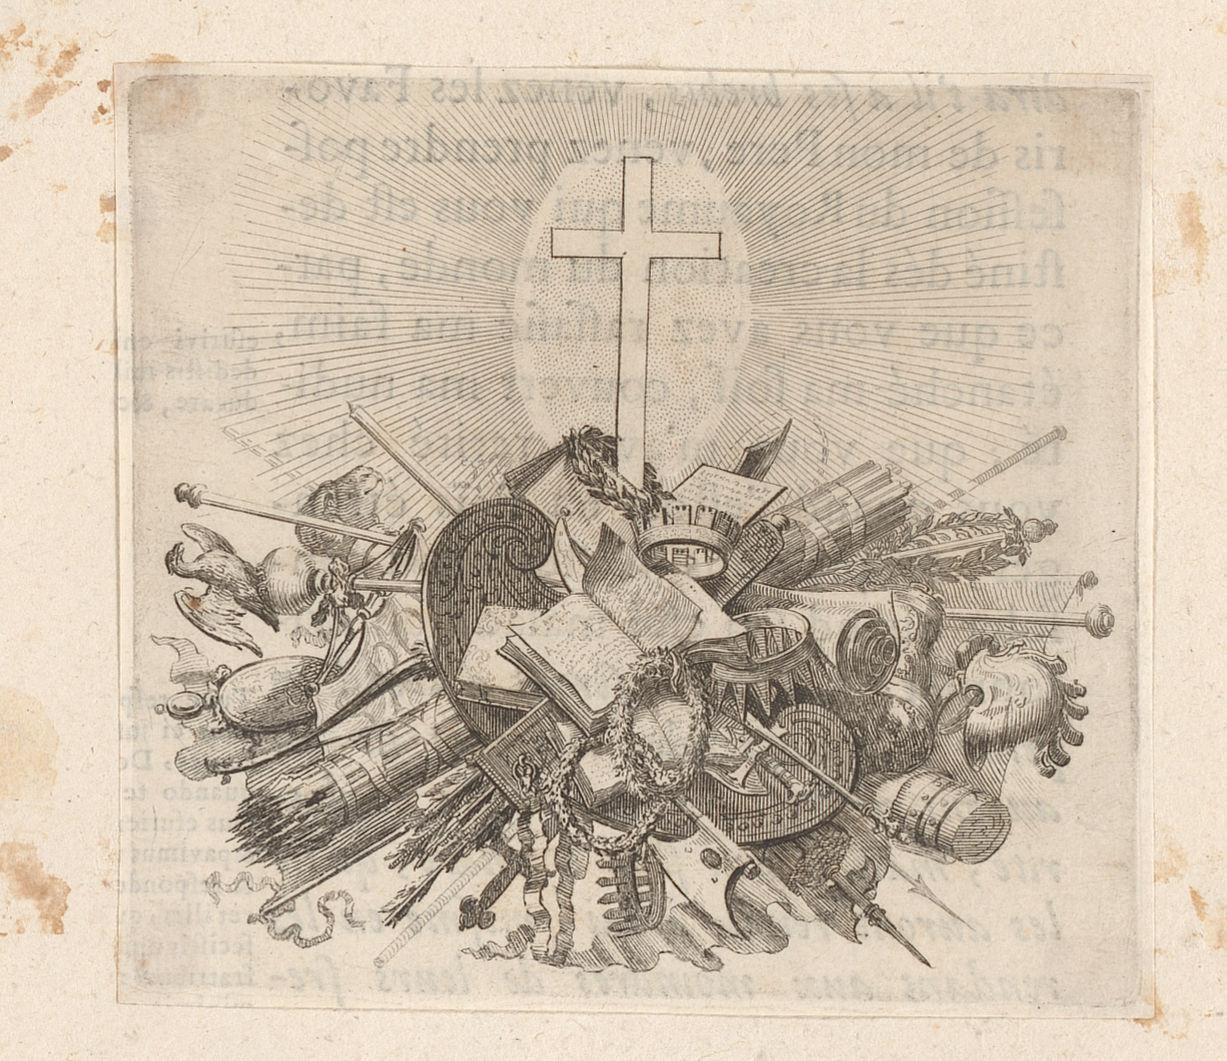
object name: book illustration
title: Cul-de-lampe met een kruis bovenop verschillende objecten als wapens en schilders attributen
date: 1678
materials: paper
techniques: etching, letterpress printing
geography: paris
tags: cross as symbol of christ, weapons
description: Prent uit: Saint-Réal, César Vichard, abbé de. La Vie de Jesus-Christ. Parijs: René Guignard, 1678.